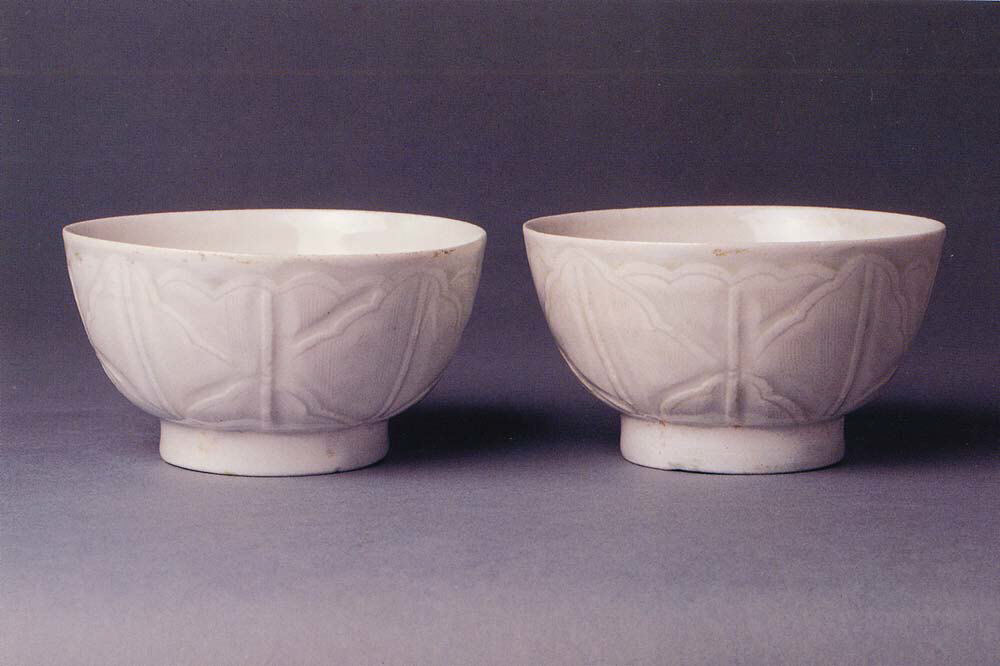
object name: bowl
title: Bowl (one of a pair)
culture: chinese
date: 901-1100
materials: glaze, porcelain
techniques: carving